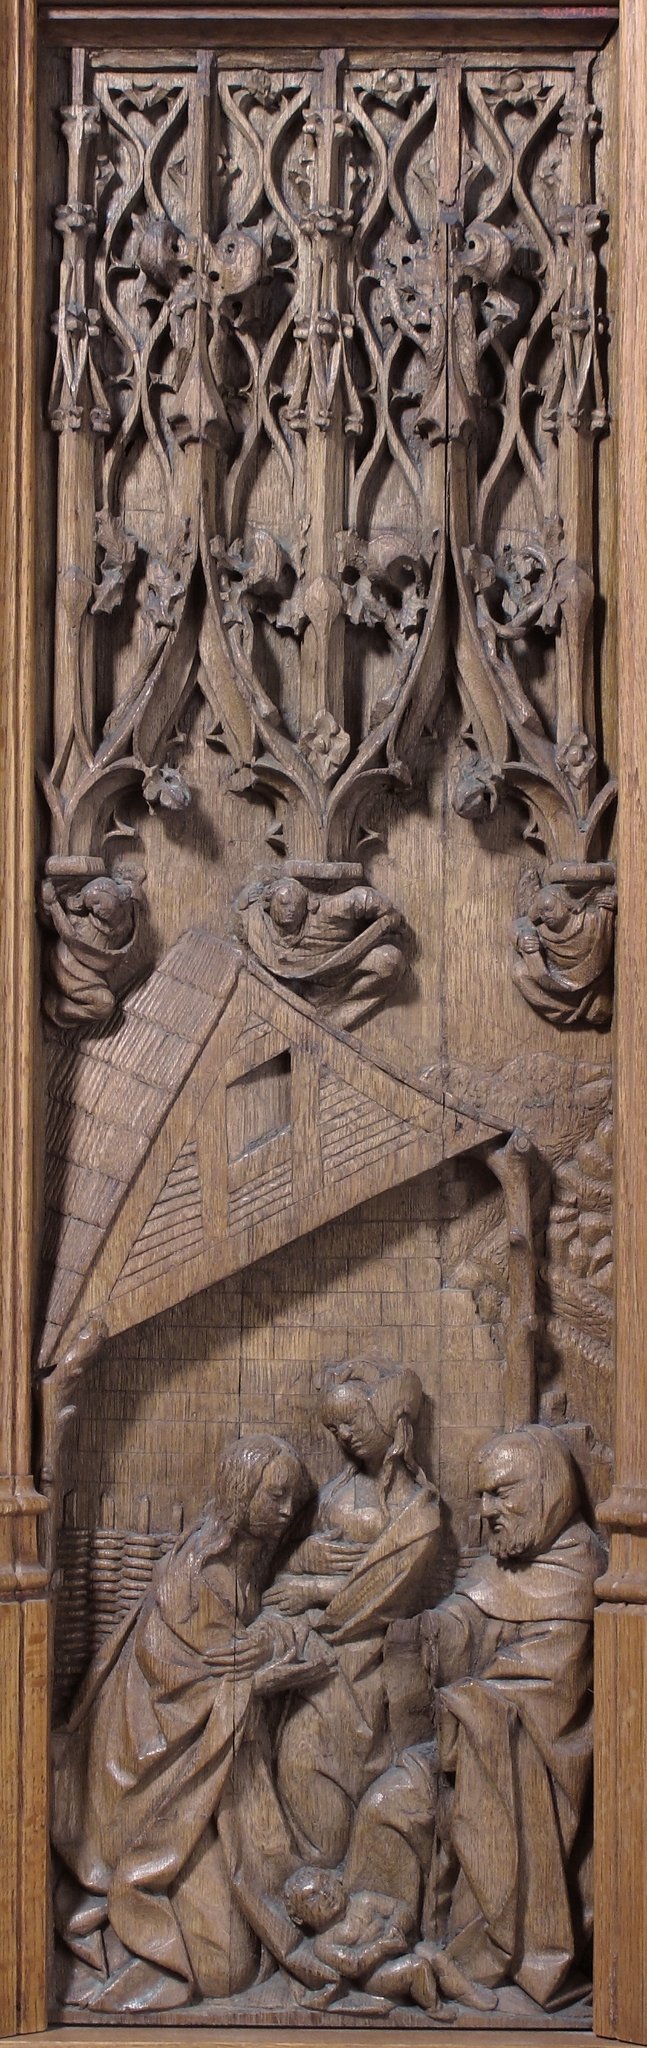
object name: panel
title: Panel with the Nativity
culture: french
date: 1501-1533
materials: wood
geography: france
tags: christ,virgin mary,nativity